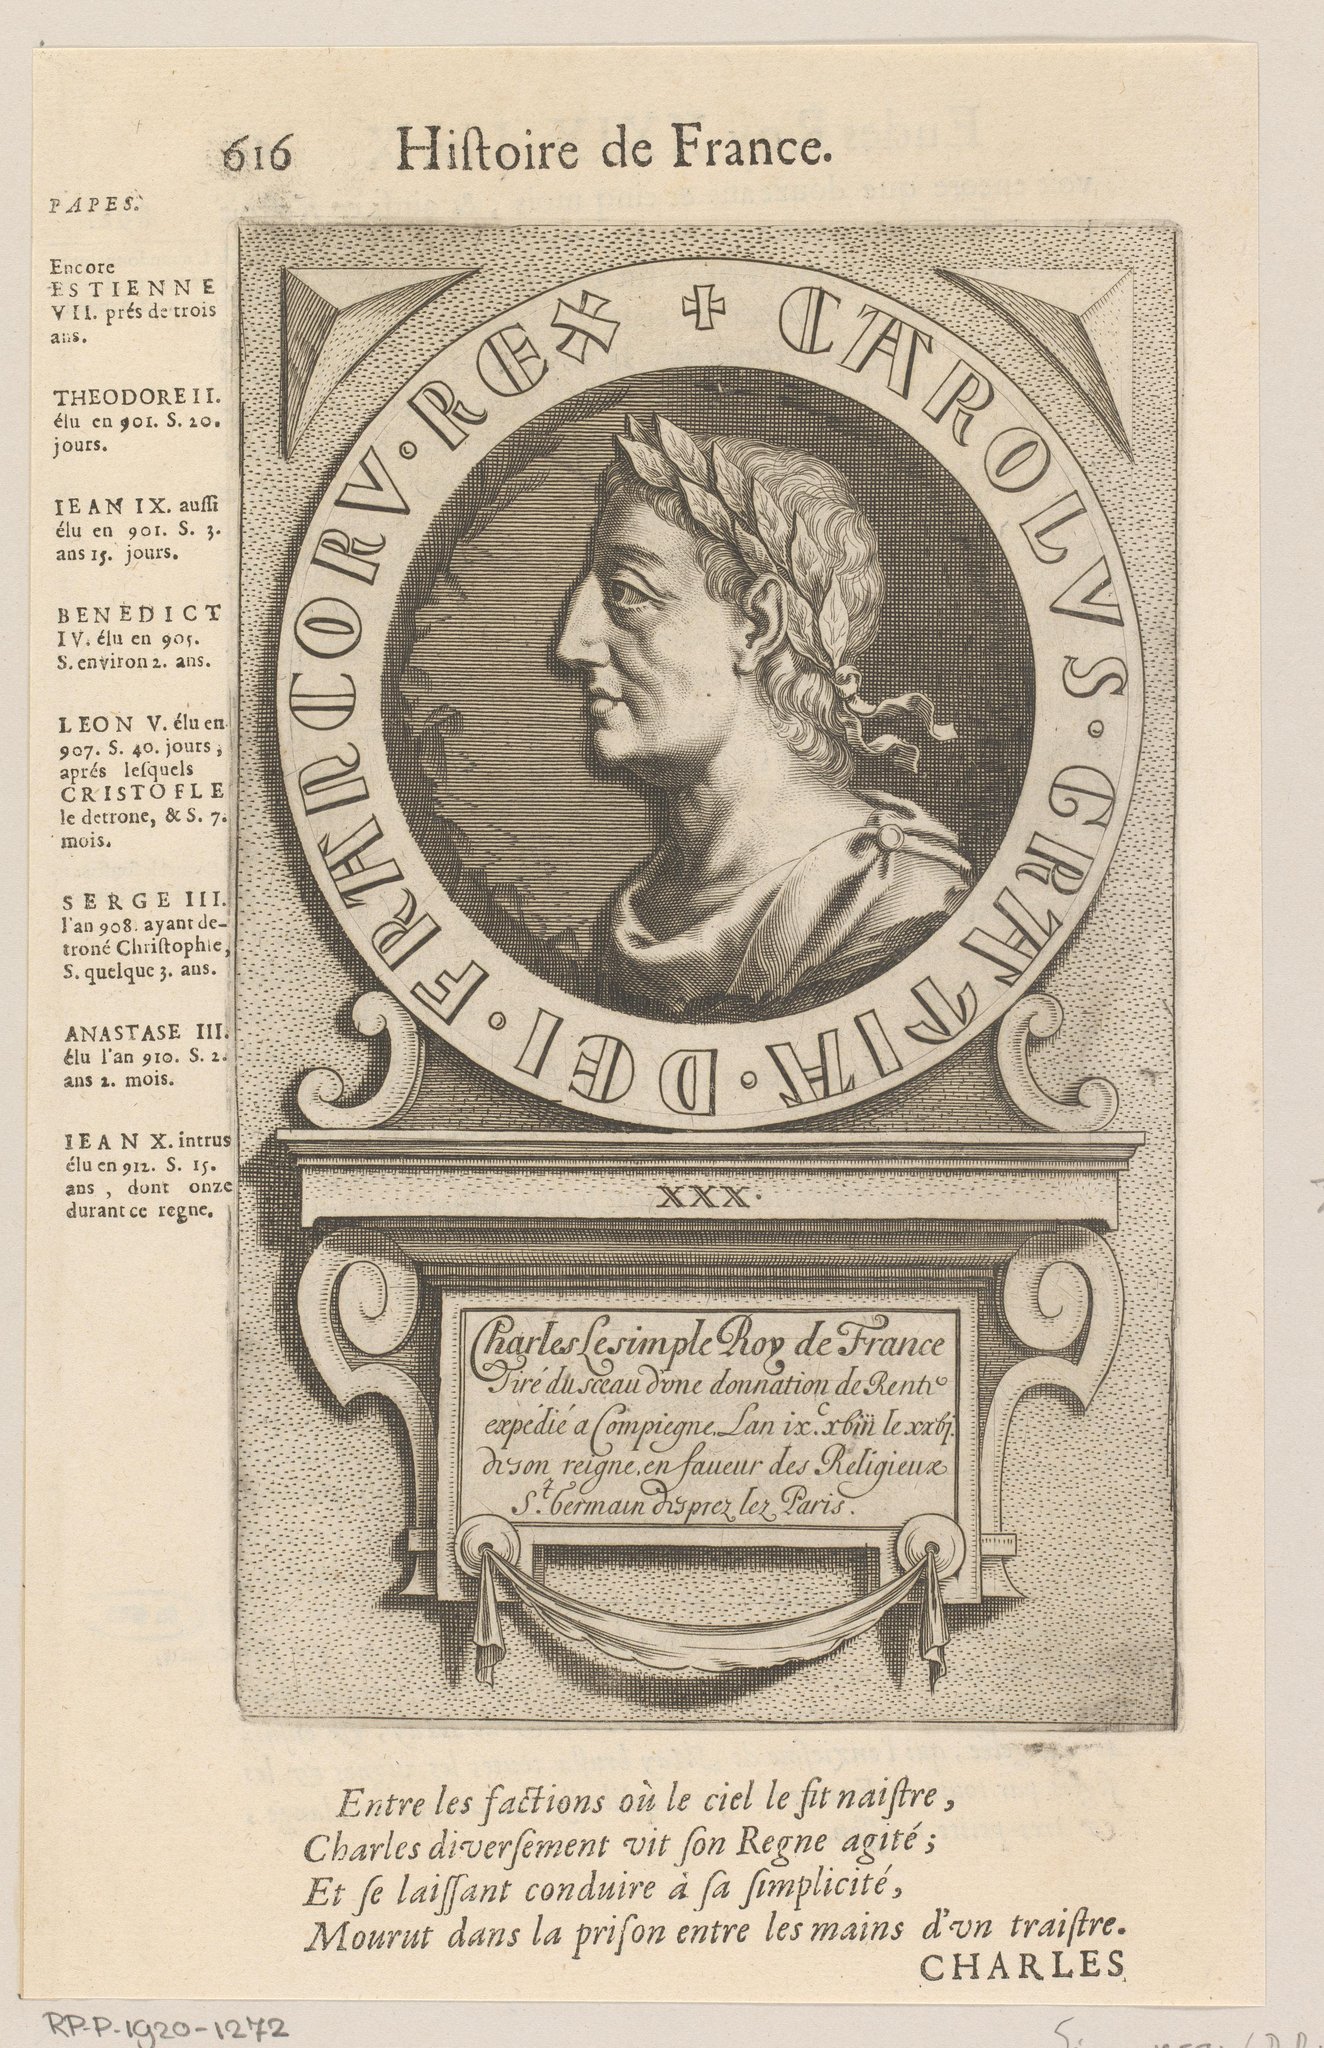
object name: book illustration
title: Charles le Simle roy de France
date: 1635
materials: paper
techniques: engraving, letterpress printing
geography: paris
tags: historical persons, ruler, sovereign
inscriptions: collector's mark: Lugt 2228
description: Prent uit: Eudes de Mézeray, François. Histoire de France, depuis Faramond jusqu’au regne de Louis le Juste (...). 3 dln. Parijs: Denis Thierry, Jean Guignard en Claude Barbin, 1635, dl. 1. Prent waarschijnlijk voor het eerst verschenen in: Bie, Jacques de. Les vrais portraits des rois de France (...). Parijs: Jacques de Bie en Pierre Rocolet, 1634. Prent ook gebruikt in latere publicaties.